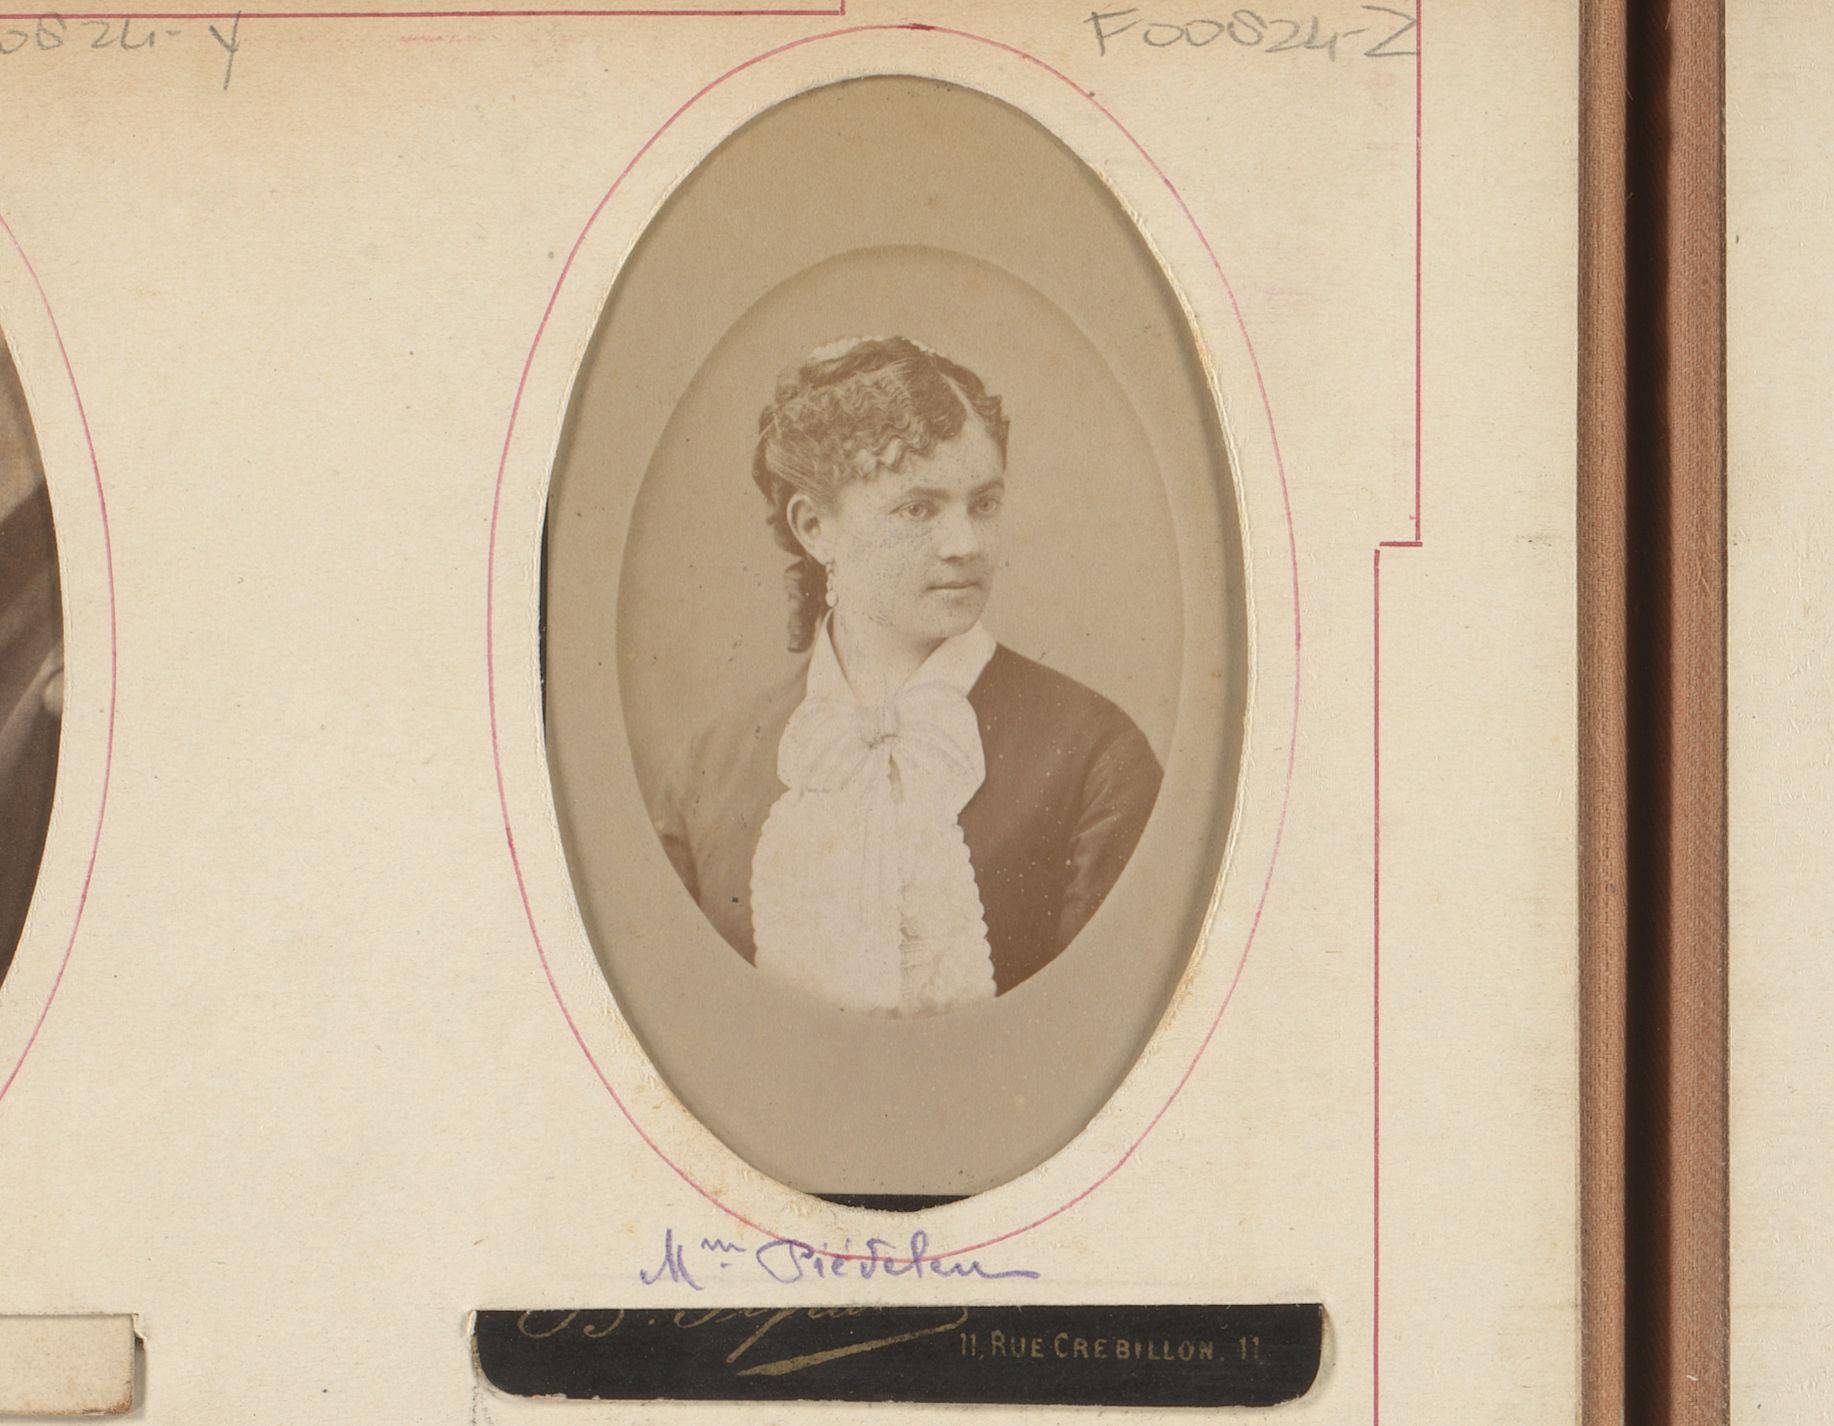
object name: photograph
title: Portret van een vrouw, aangeduid als Mme. Piédelen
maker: jean-marie pipaud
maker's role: fotograaf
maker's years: 1847-1924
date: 1886-1895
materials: cardboard, paper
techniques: albumen print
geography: nantes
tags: adult woman, anonymous historical person portrayed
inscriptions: address: ‘11, Rue Crebillon, 11/ Mon Gimilini a Nantes [?]’